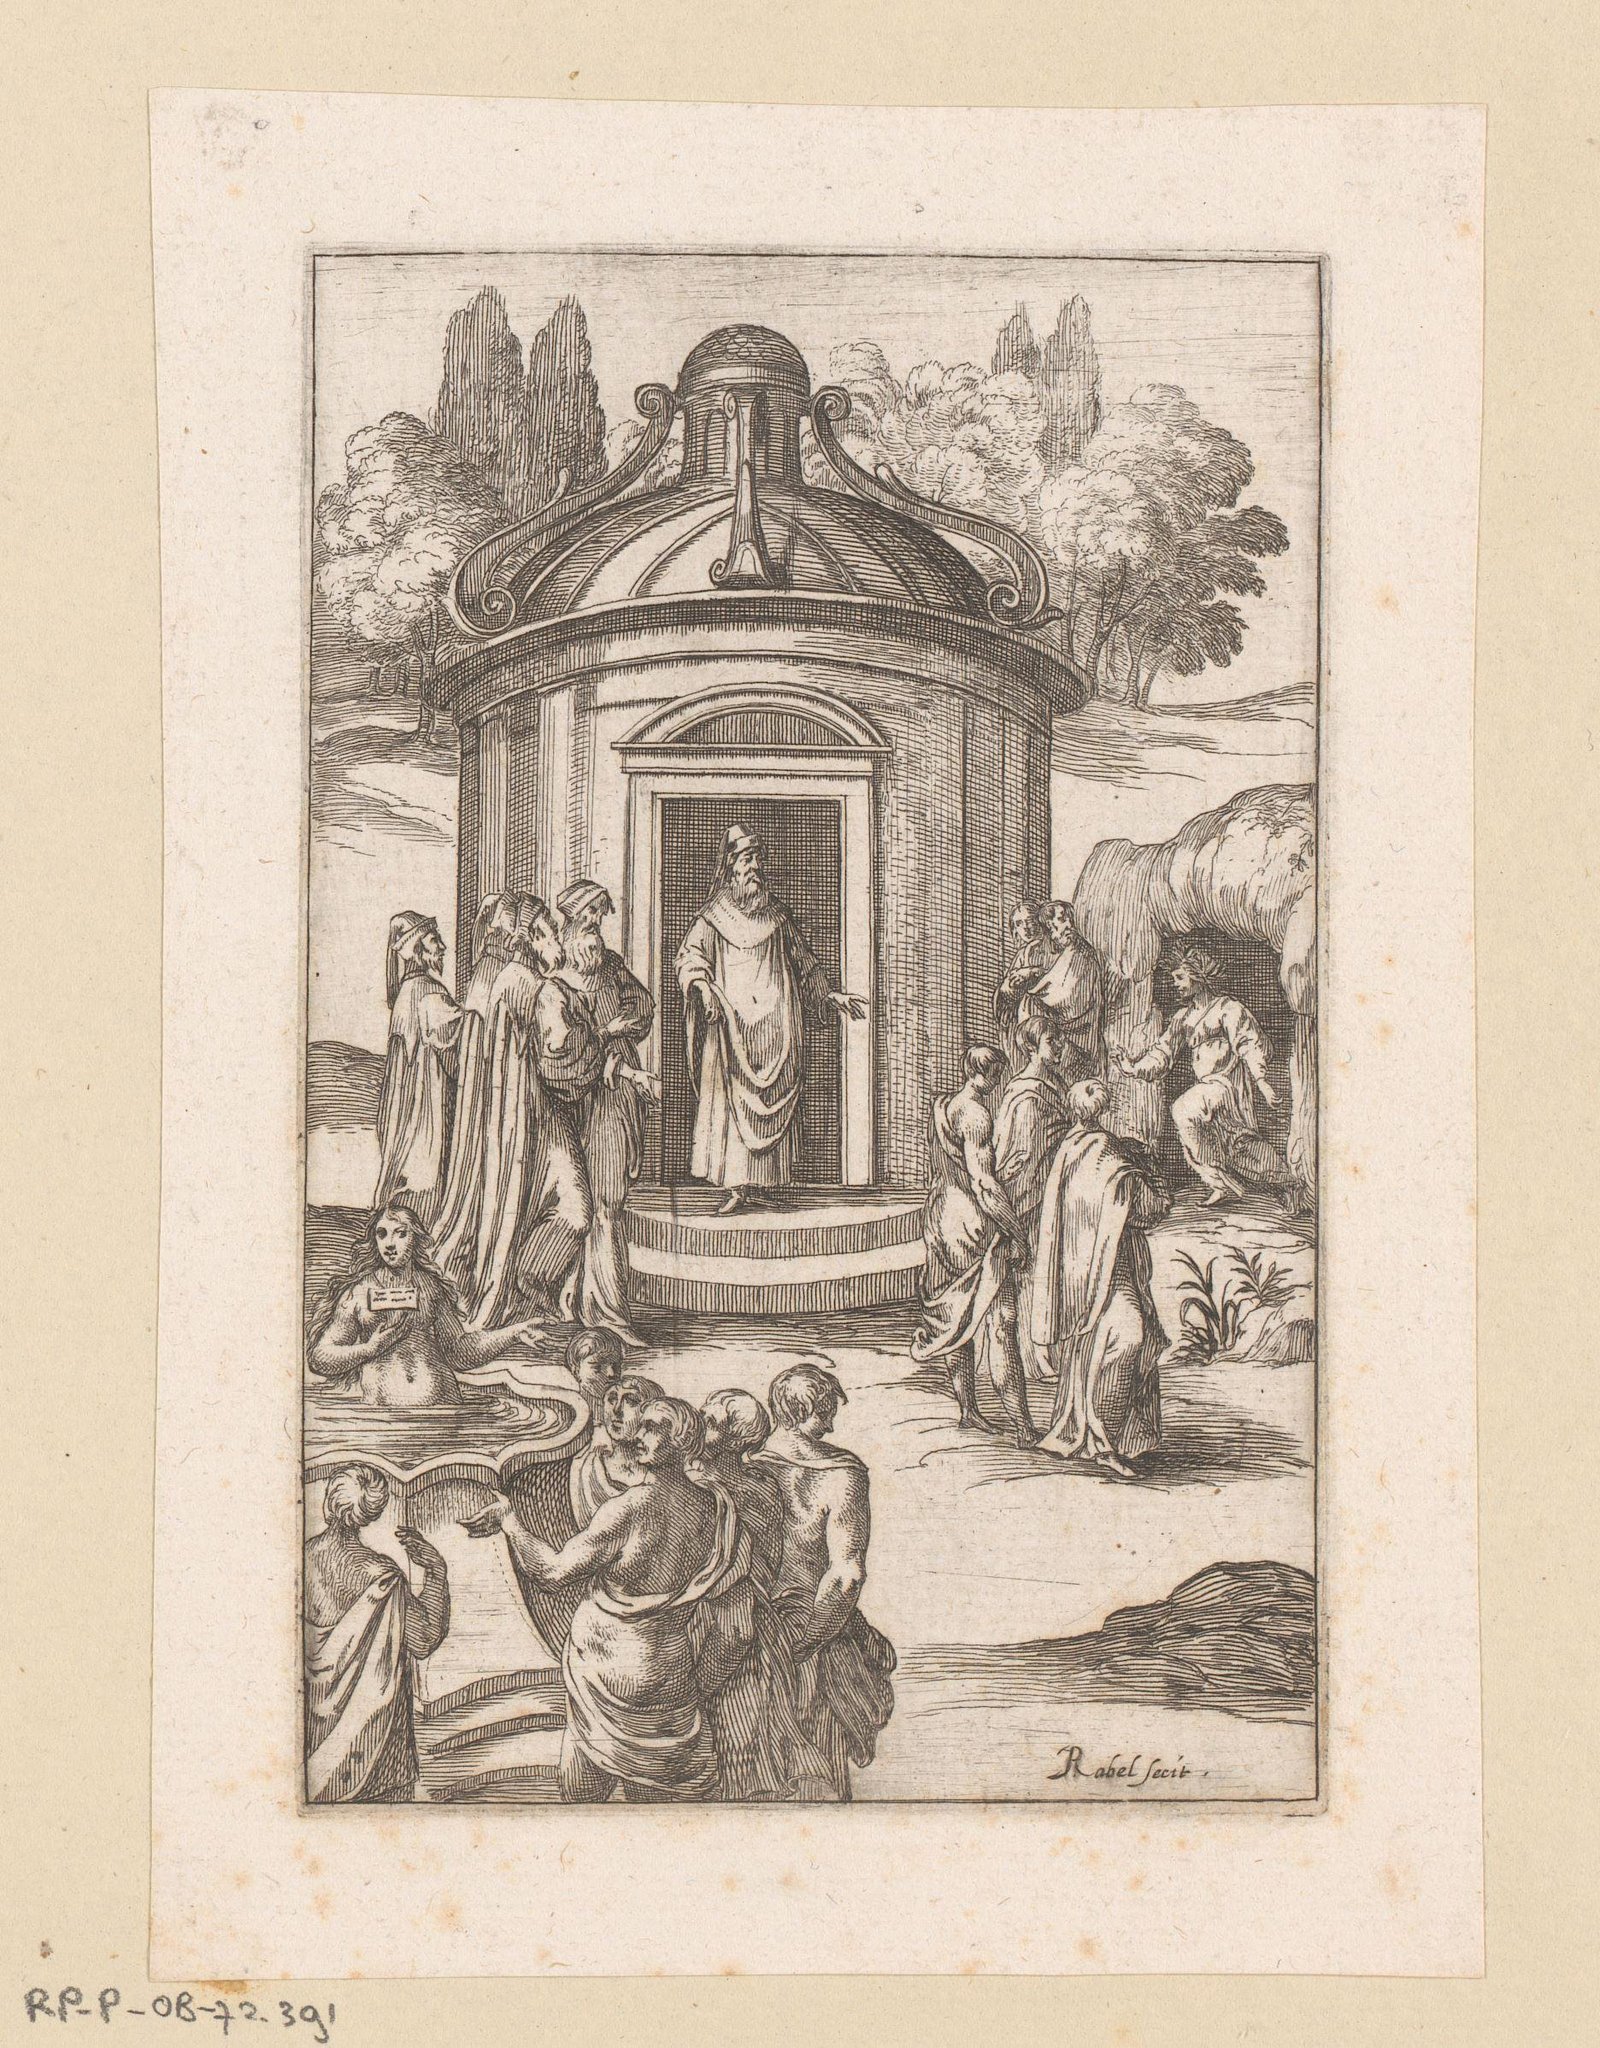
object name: print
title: Priesters bij een ronde tempel, met daarvoor een vrouw in een waterbassin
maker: daniel rabel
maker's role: print maker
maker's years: 1578-1637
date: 1588-1637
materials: paper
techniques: etching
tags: temple, shrine ~ greek religion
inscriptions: collector's mark: Lugt 240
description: Rechts op de achtergrond komt een vrouw uit een grot.